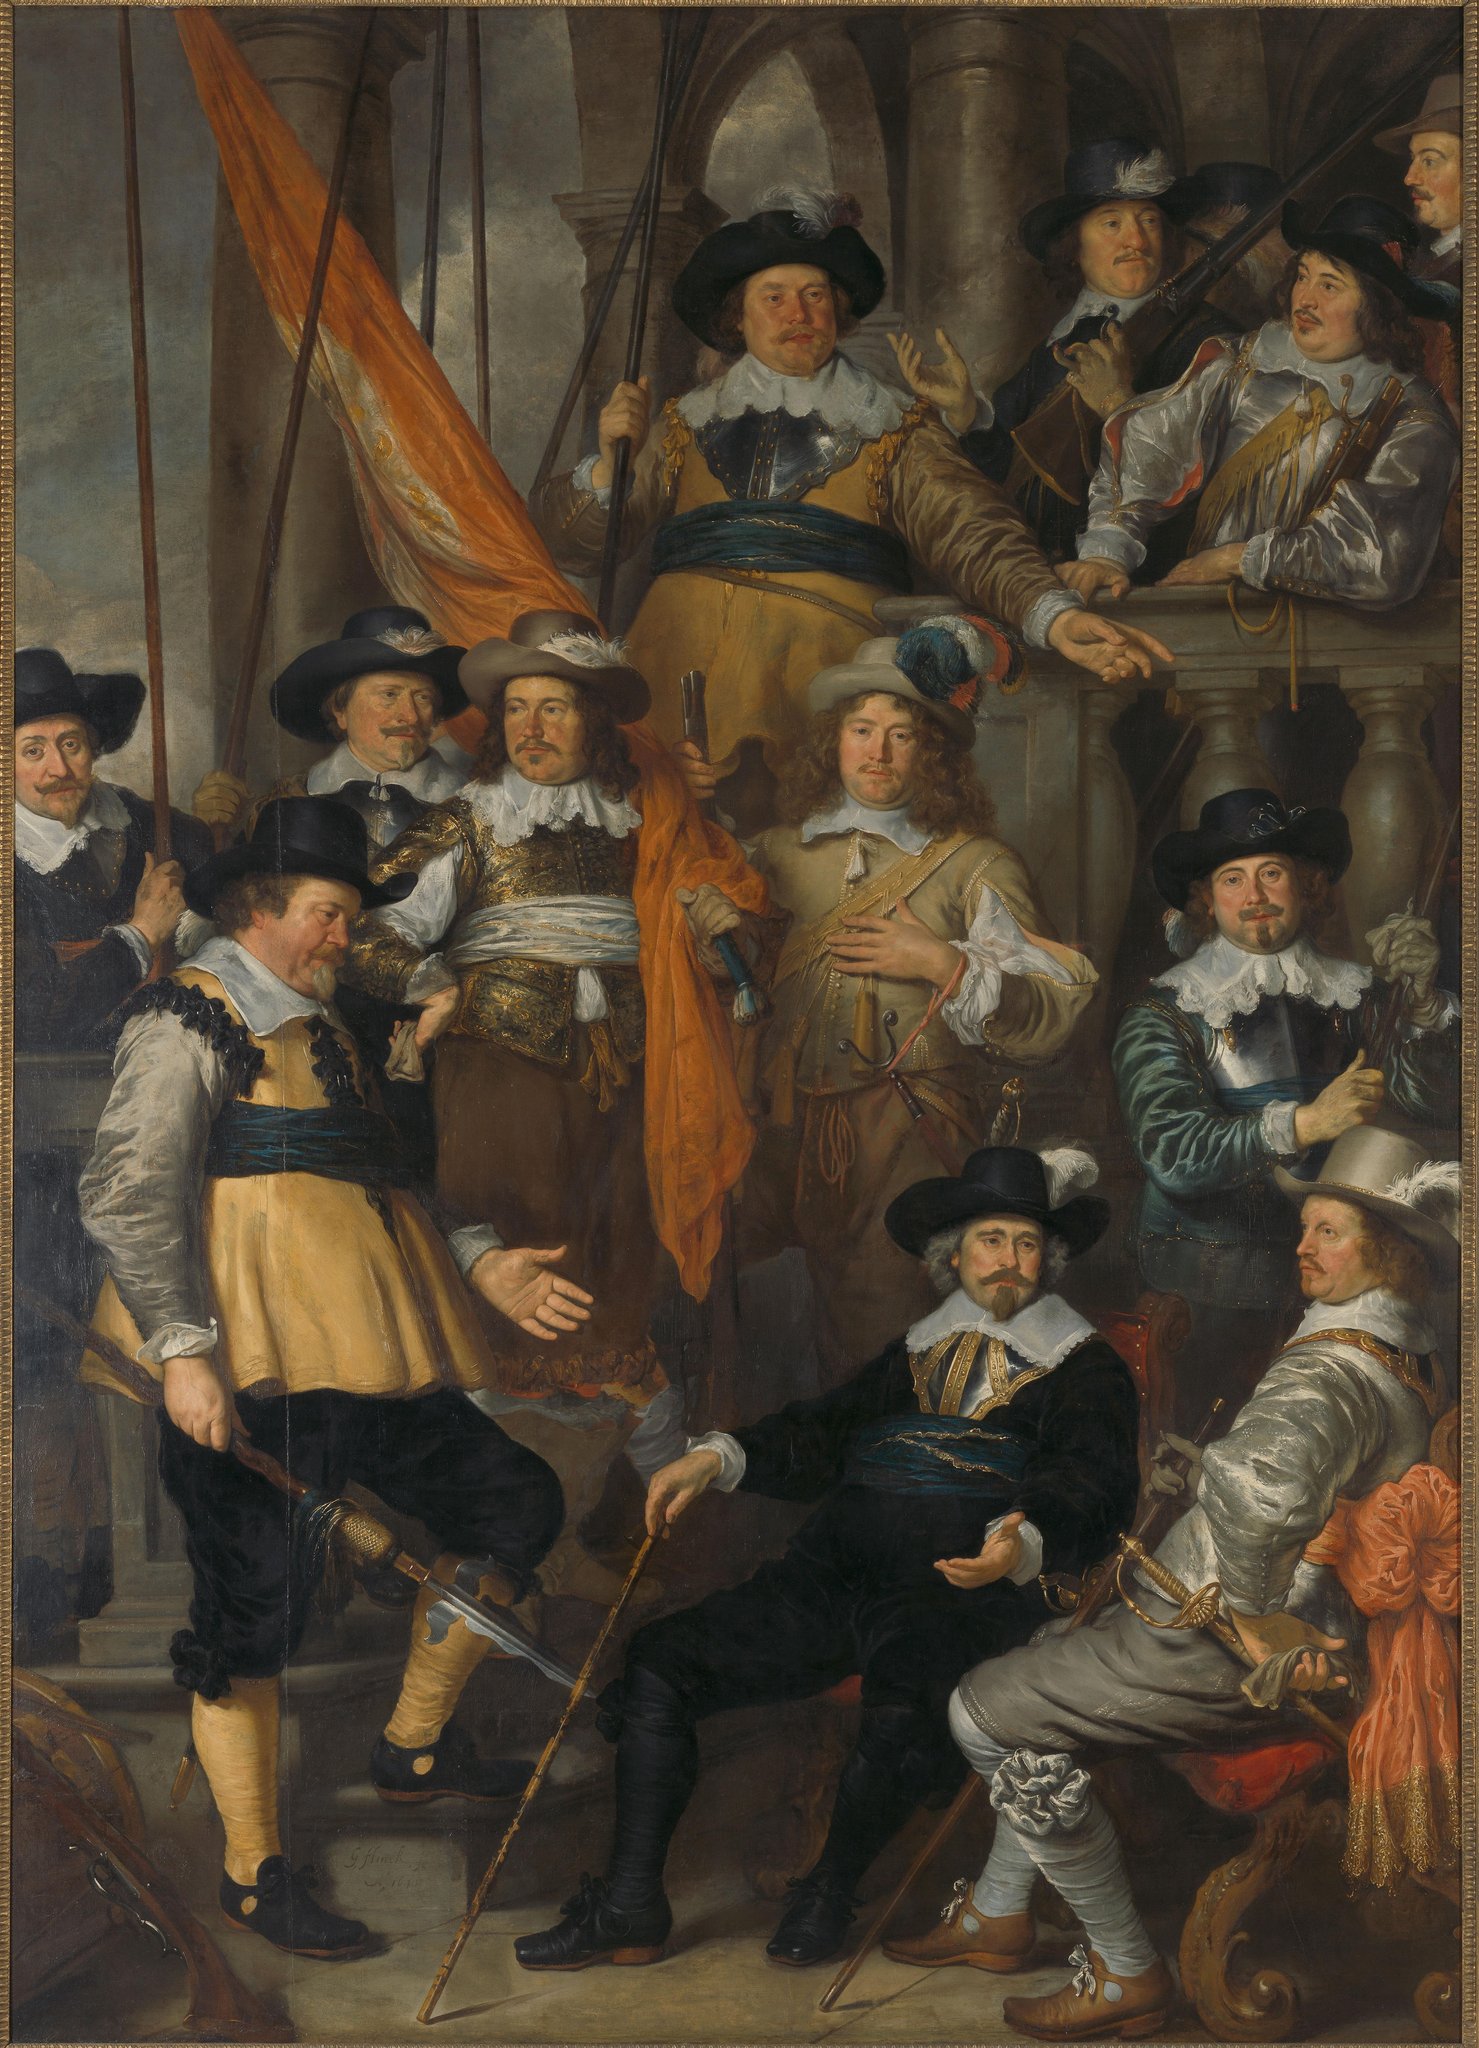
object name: painting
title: The Company of Captain Albert Bas and Lieutenant Lucas Conijn, 1645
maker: govert flinck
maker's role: draughtsman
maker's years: 1615-1660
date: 1645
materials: canvas, oil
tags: amsterdam, warfare; military affairs (+ citizen soldiery, civil guard, citizen militia), firearms, helved weapons, polearms (for striking, hacking, thrusting): halberd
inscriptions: signature and date, lower left, on the step beneath the foot of Lieutenant Conijn: ‘G. flinck. fe: / A.º 1645’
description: Govert Flinck (1615 - 1660). The company of Captain Alber t Bas, 1645. Gover t Flinck has arranged his subjects in a circle around Captain Albert Bas. He did not have a great deal of choice, due to the fixed dimensions of his painting. The size was dictated by the spot for which the work was intended: the relatively narrow space next to the fireplace in the Kloveniersdoelen. The Amsterdam civic guard had recently expanded its headquarters, and the walls of the enormous new doelenzaal or militia hall were decorated with six large civic guard paintings. In addition to this work by Flinck, they included the Night-watch by Rembrandt and civic guard works by Joachim von Sandrart and Bartholomeus van der Helst; all three are also hanging in this room. Painted for the Grand Hall of the Kloveniersdoelen (headquarters of the crossbowmen's civic guard), Amsterdam. On loan from the city of Amsterdam, 1885.